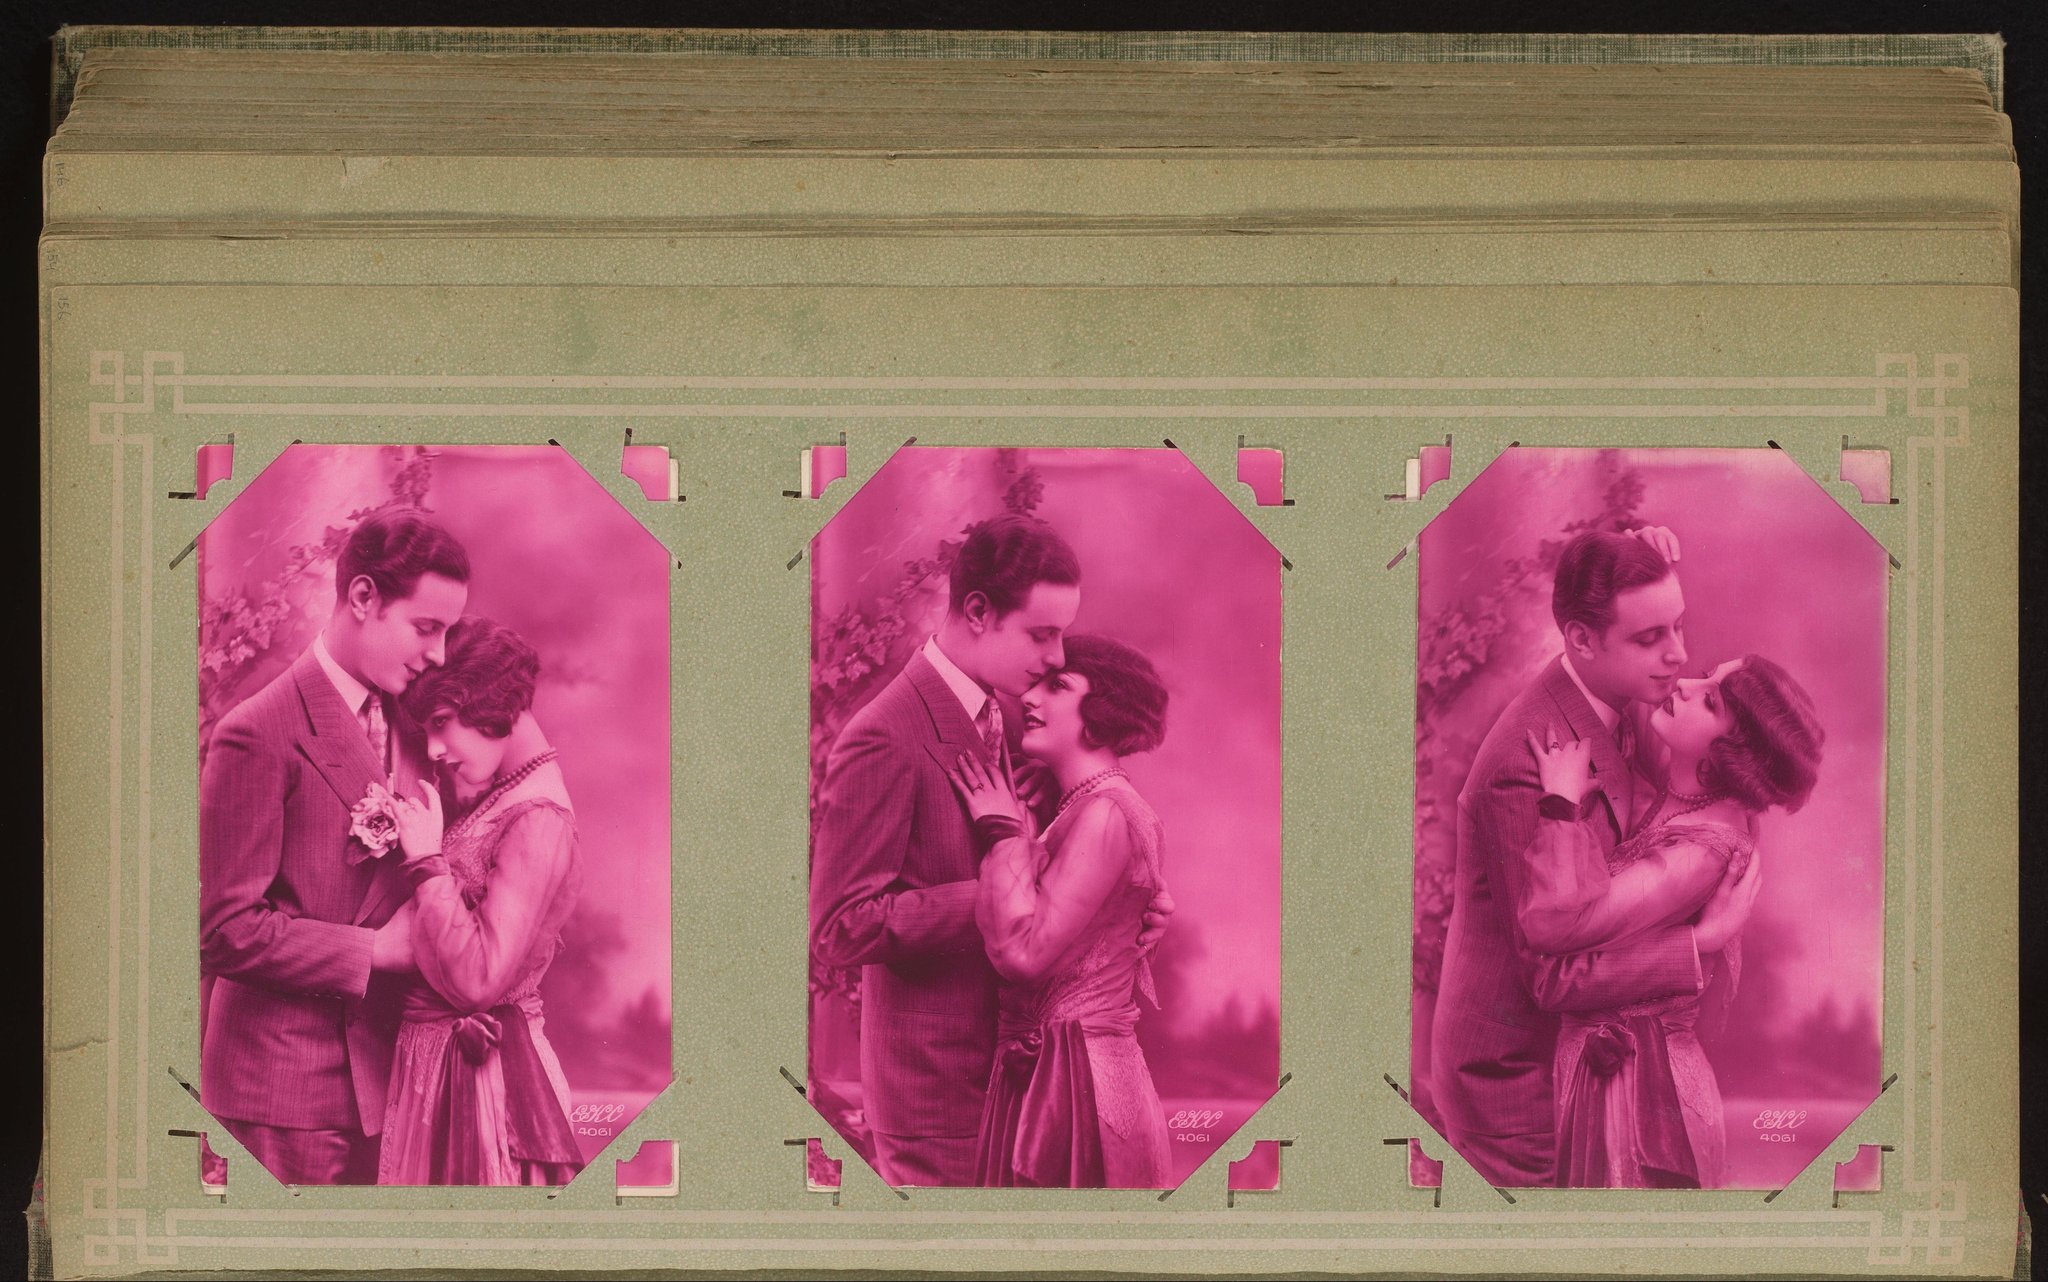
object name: ansichtkaart, prentbriefkaart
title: Drie portretten van een paar geliefden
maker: Anonymous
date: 1900-1930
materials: cardboard, photographic support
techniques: gelatin silver print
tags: historical persons - bb - woman, historical persons, couple of lovers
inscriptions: monogram: ‘EKC’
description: Deze foto's maken deel uit van een album.